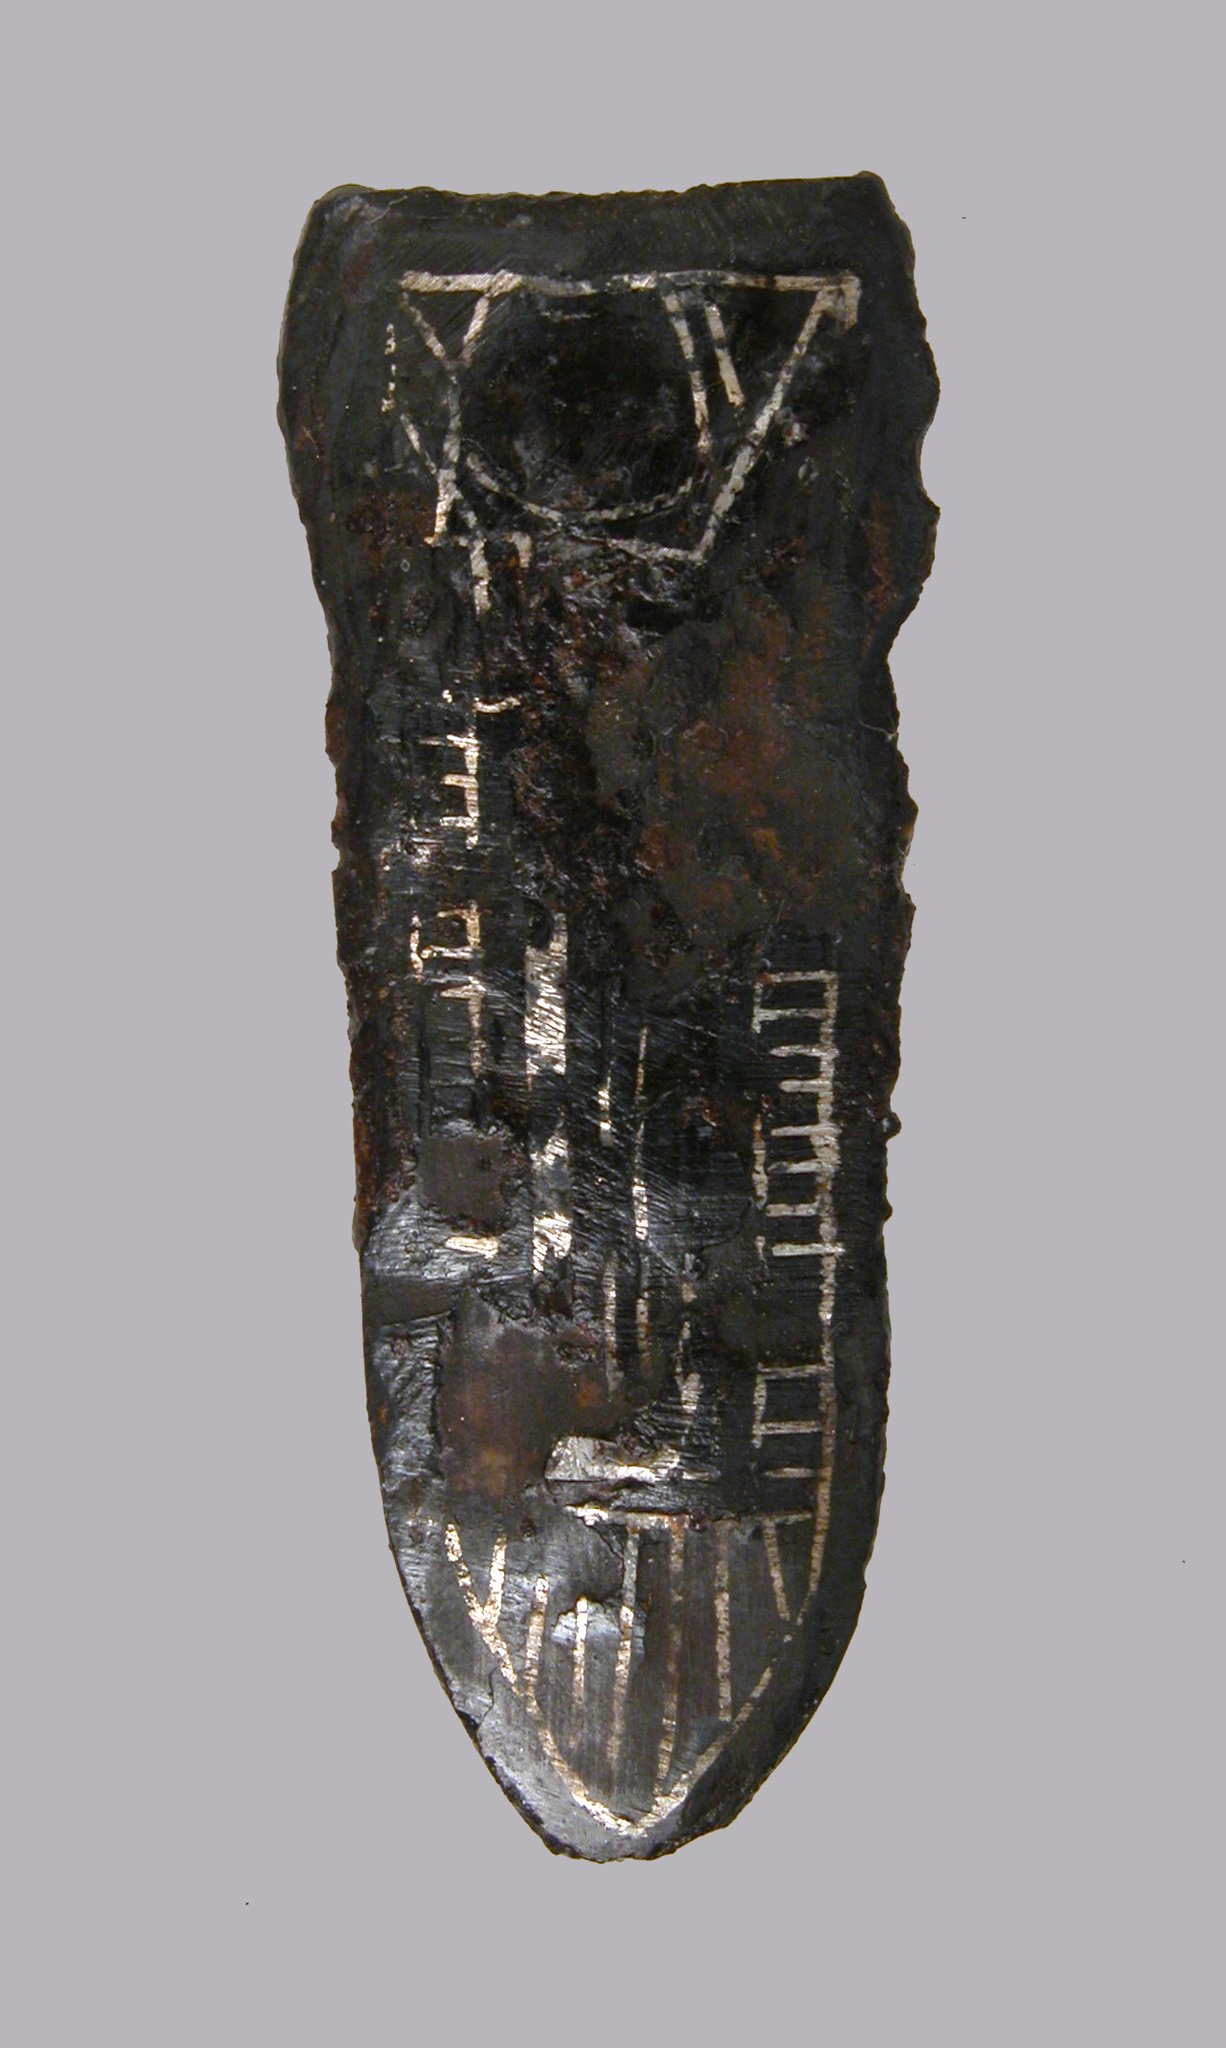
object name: belt strap end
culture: burgundian or frankish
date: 301-700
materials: iron, silver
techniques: inlay